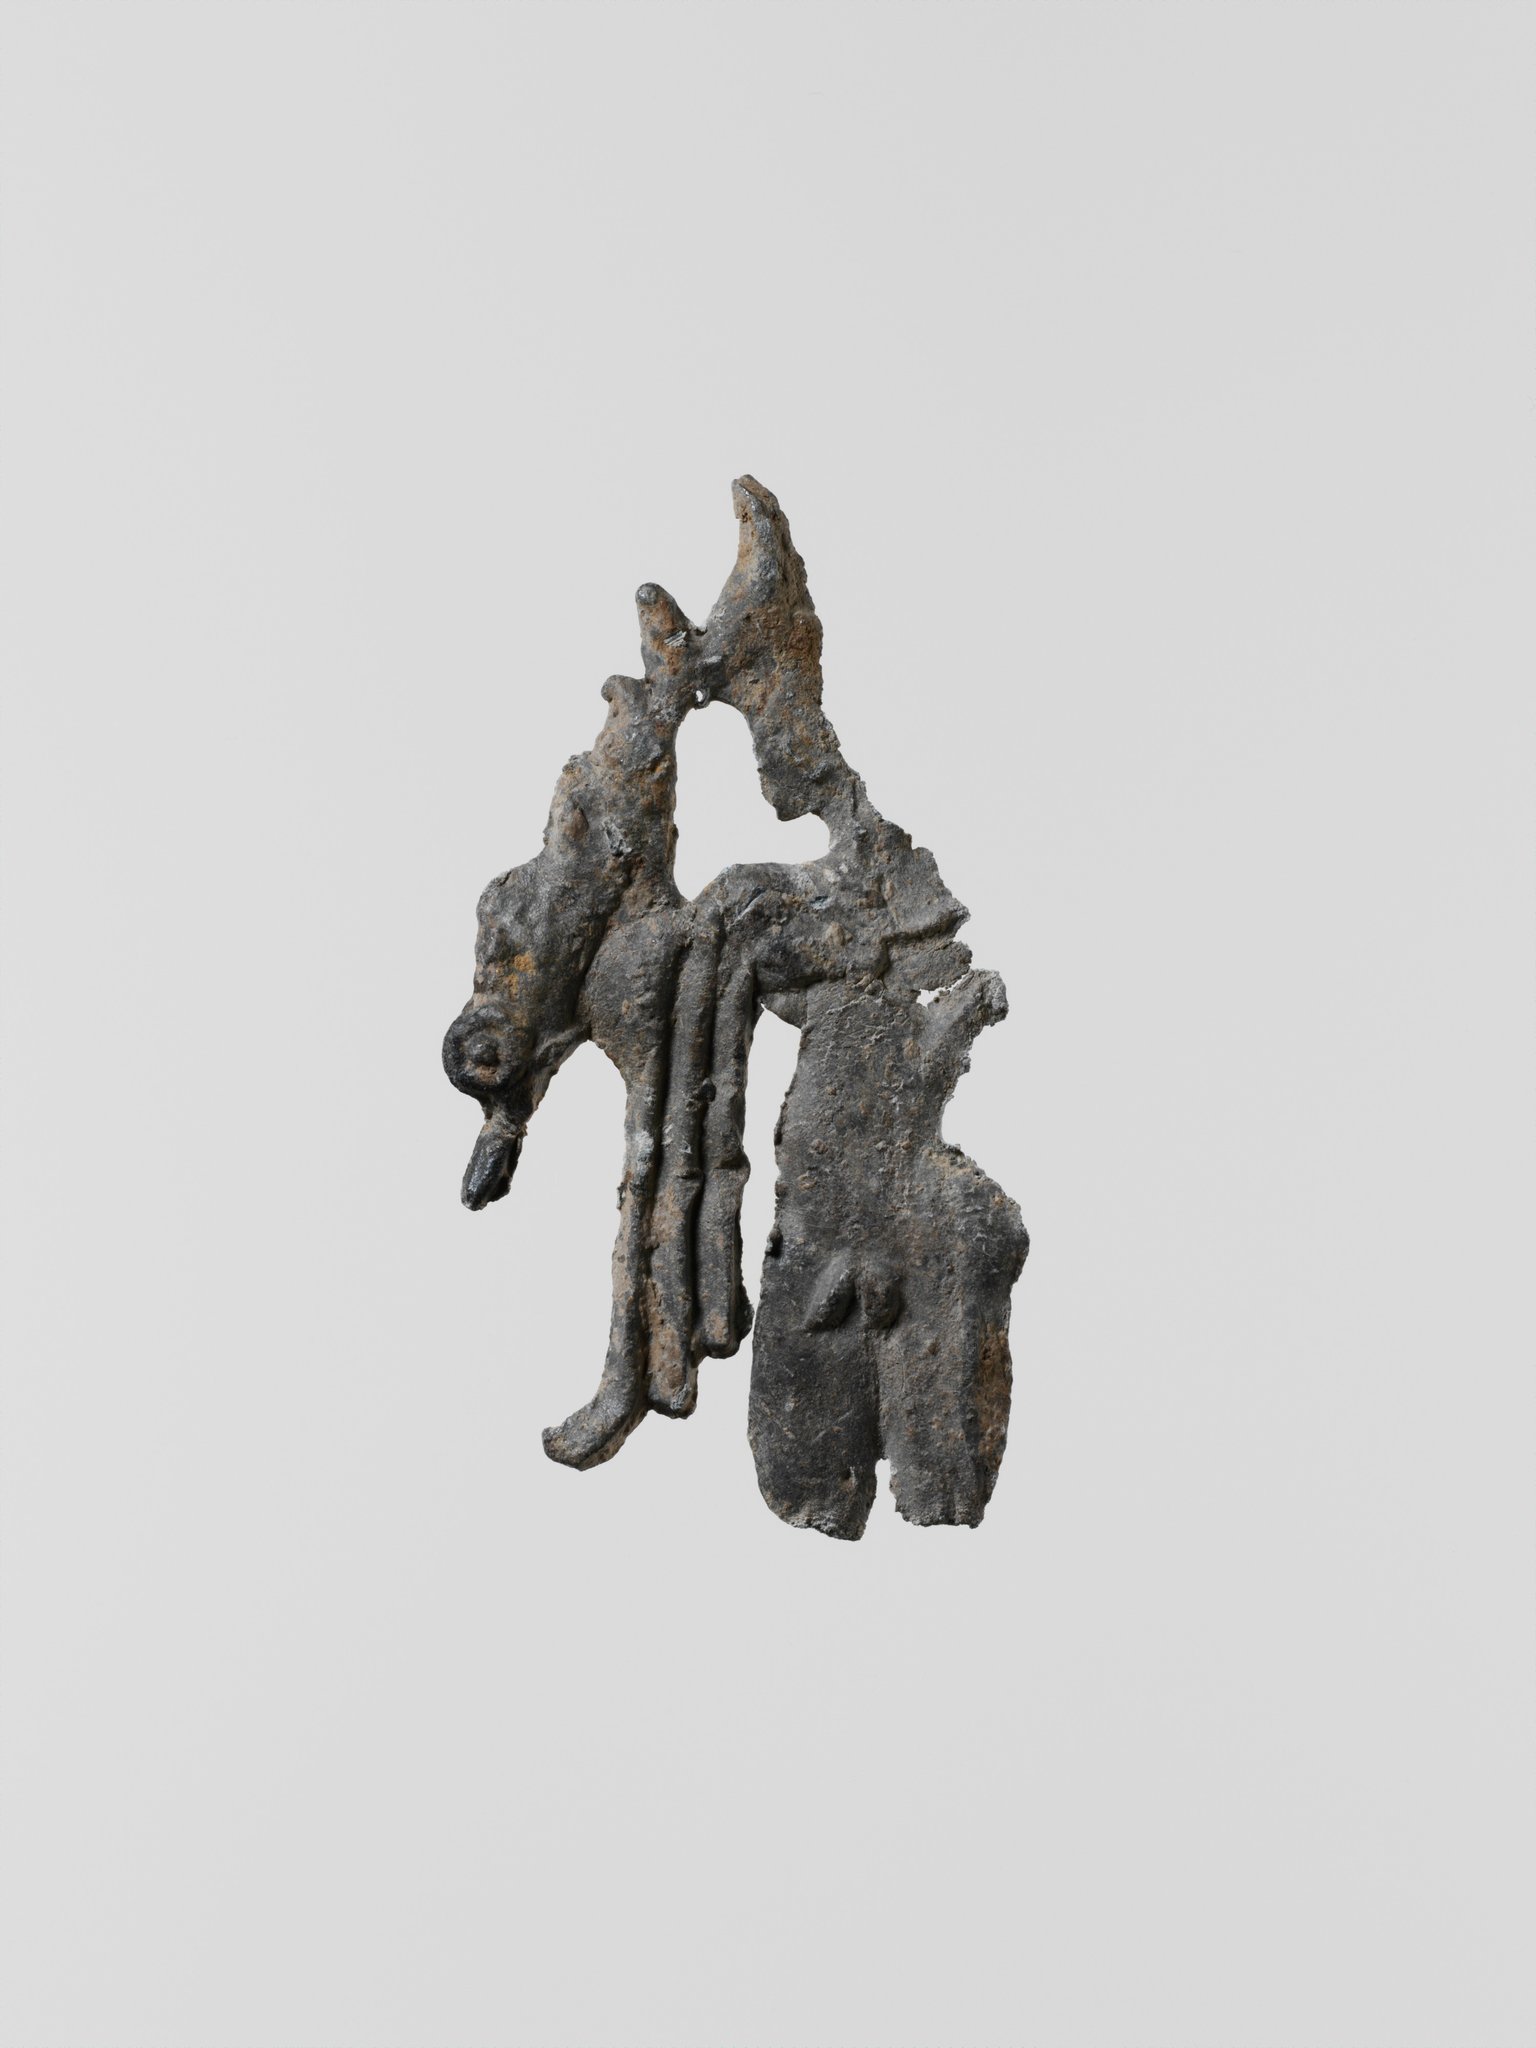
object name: statuette of poseidon, 4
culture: greek, laconian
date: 7000-30 BCE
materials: lead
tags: poseidon